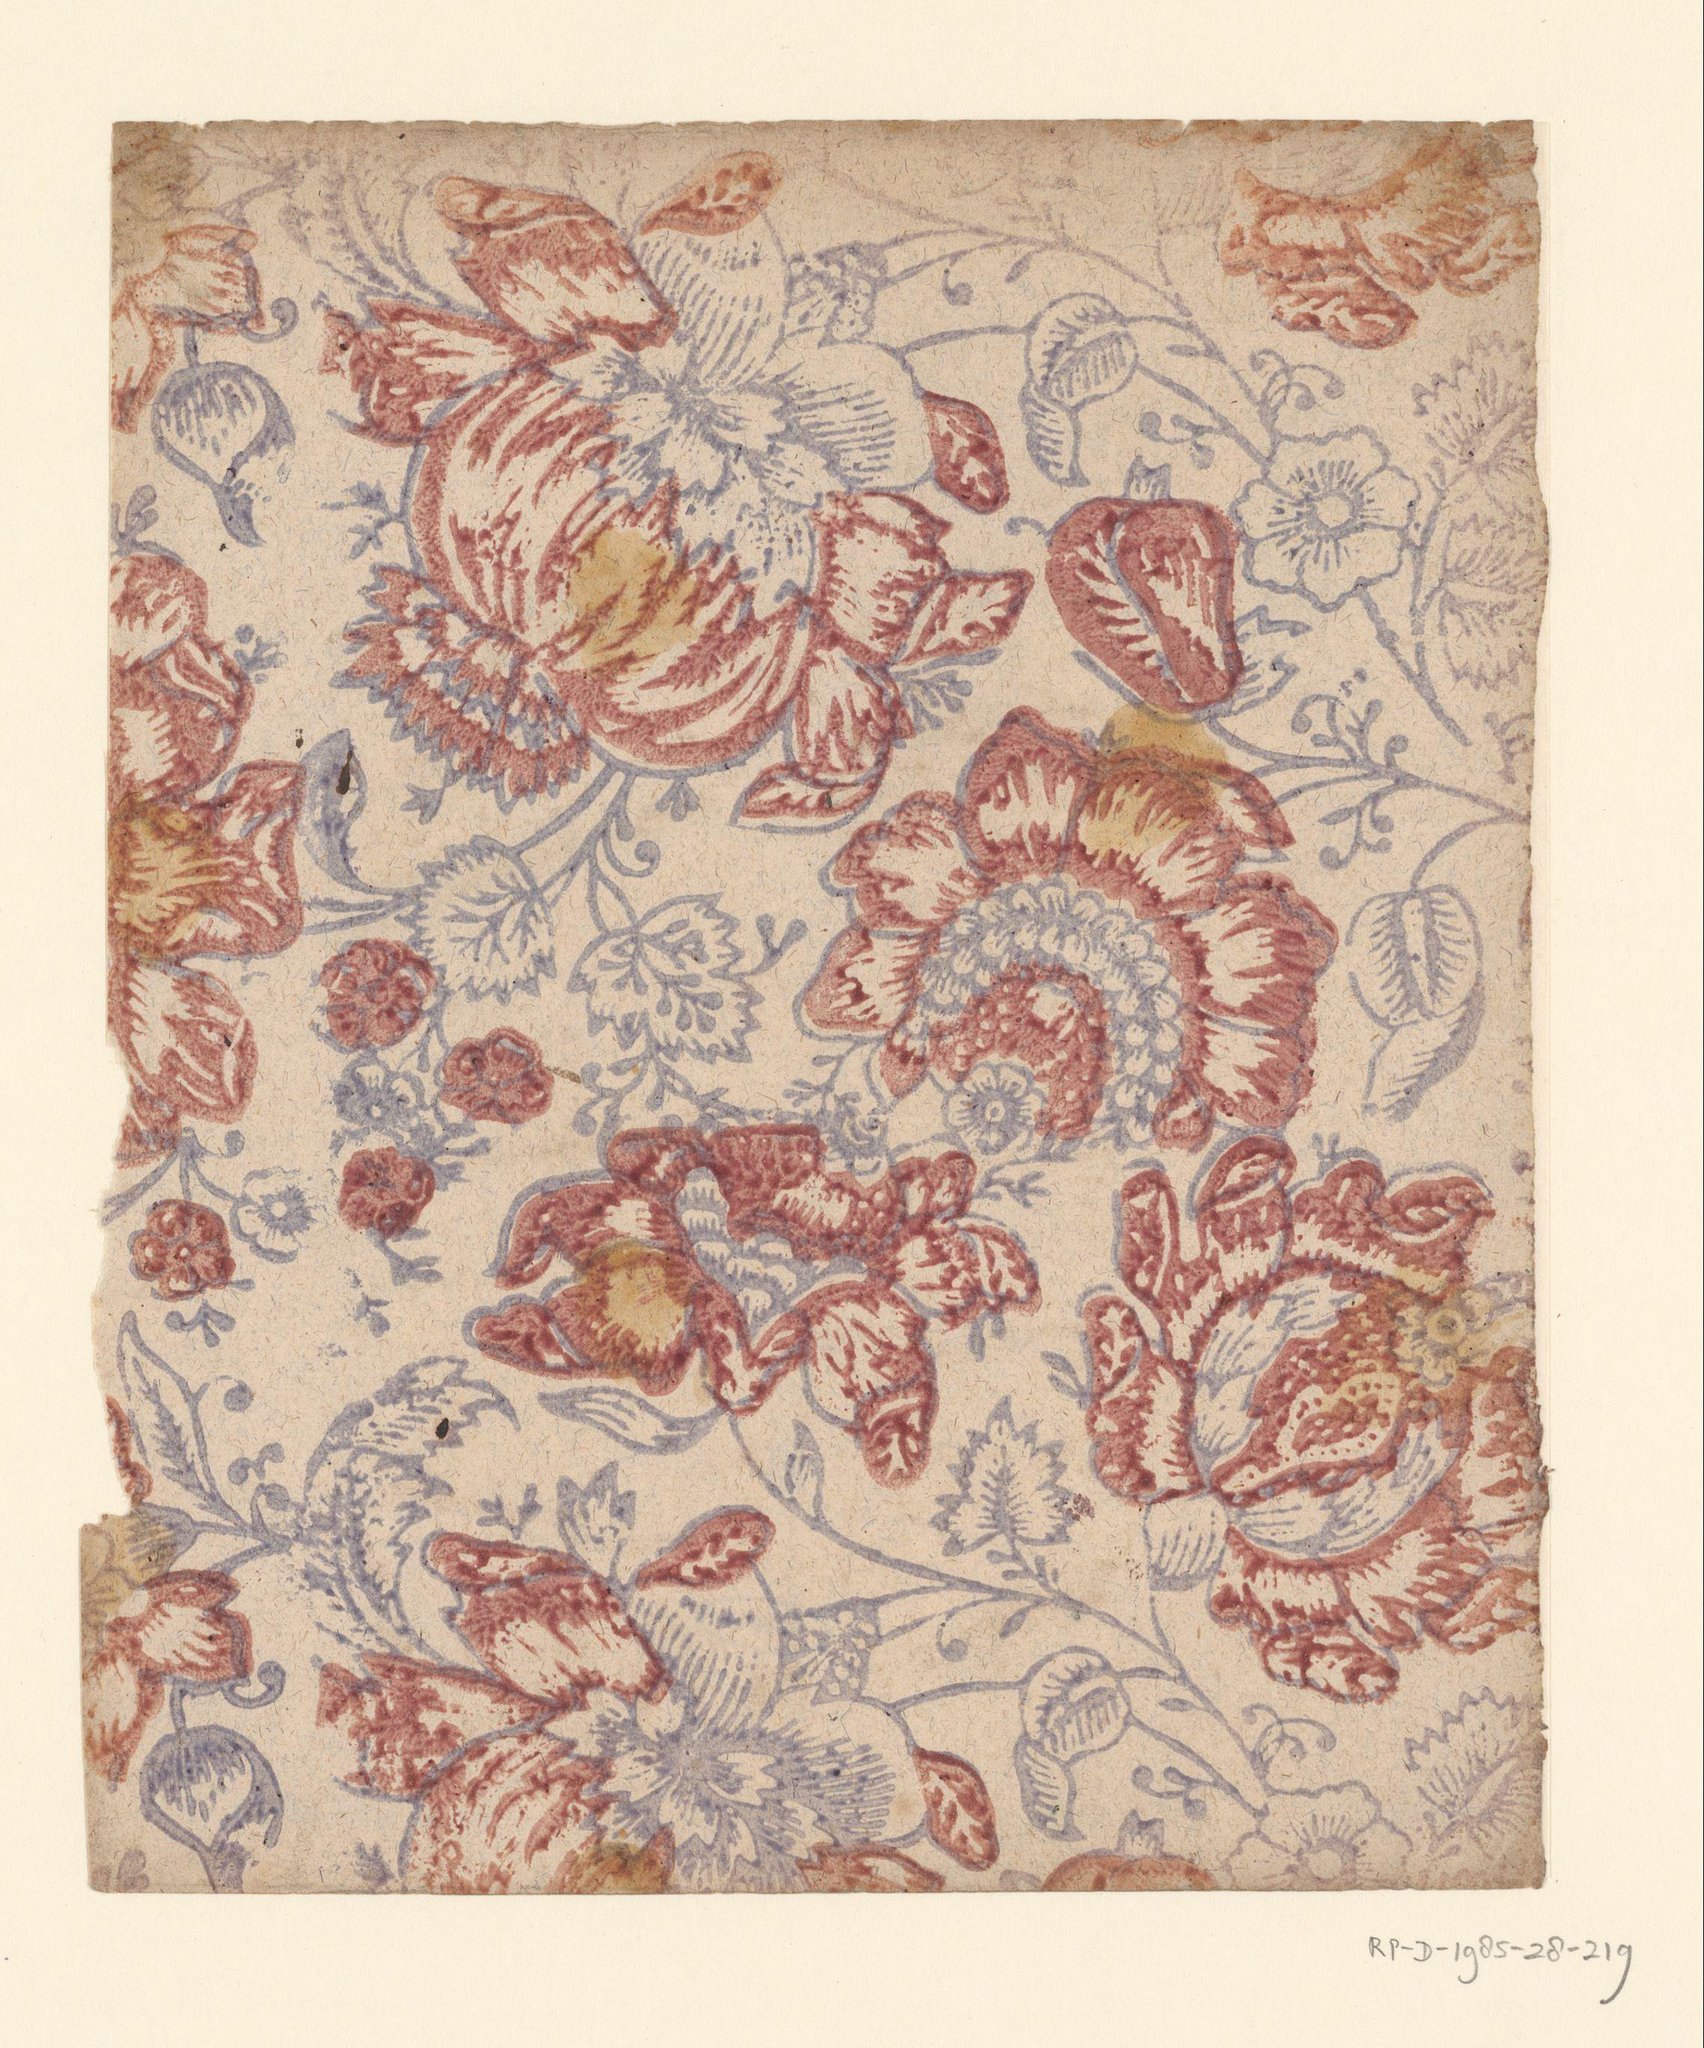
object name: printed paper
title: Blad met strooipatroon van bloemen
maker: Anonymous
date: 1750-1900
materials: paper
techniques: printing block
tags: ornament derived from plant forms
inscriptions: collector's mark: Lugt 2760, collector's mark: Lugt 2228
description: Blad met strooipatroon van bloemen. Helft van een omslag.